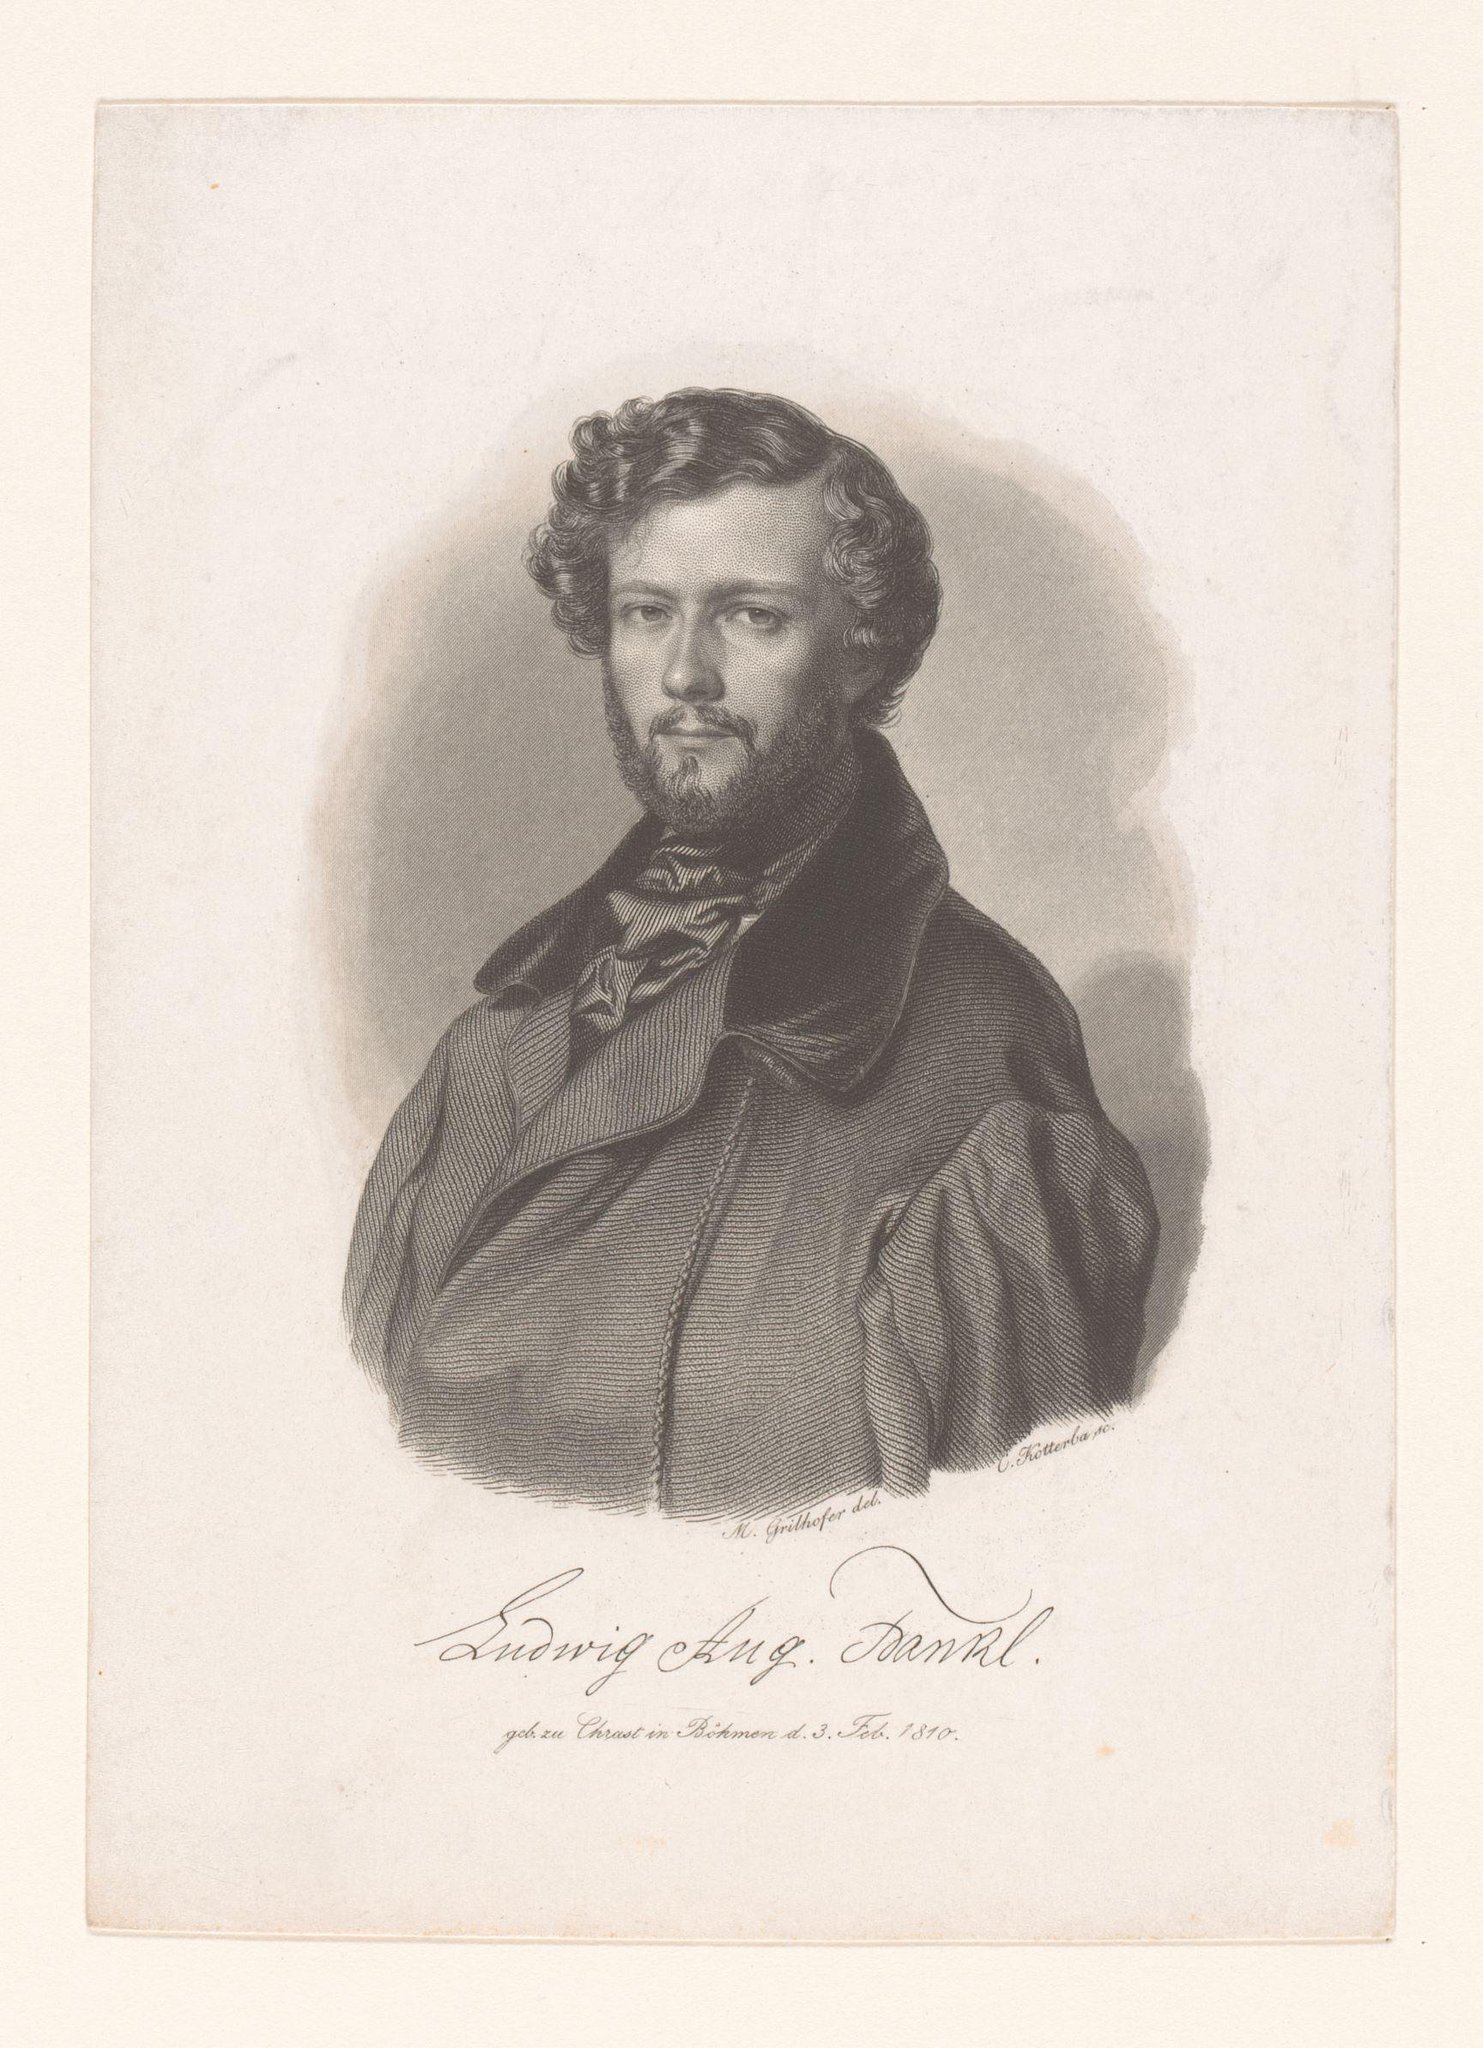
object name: book illustration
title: Ludwig Aug. Frankl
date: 1845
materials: paper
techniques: engraving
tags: publisher, historical persons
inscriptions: collector's mark: Lugt 2228